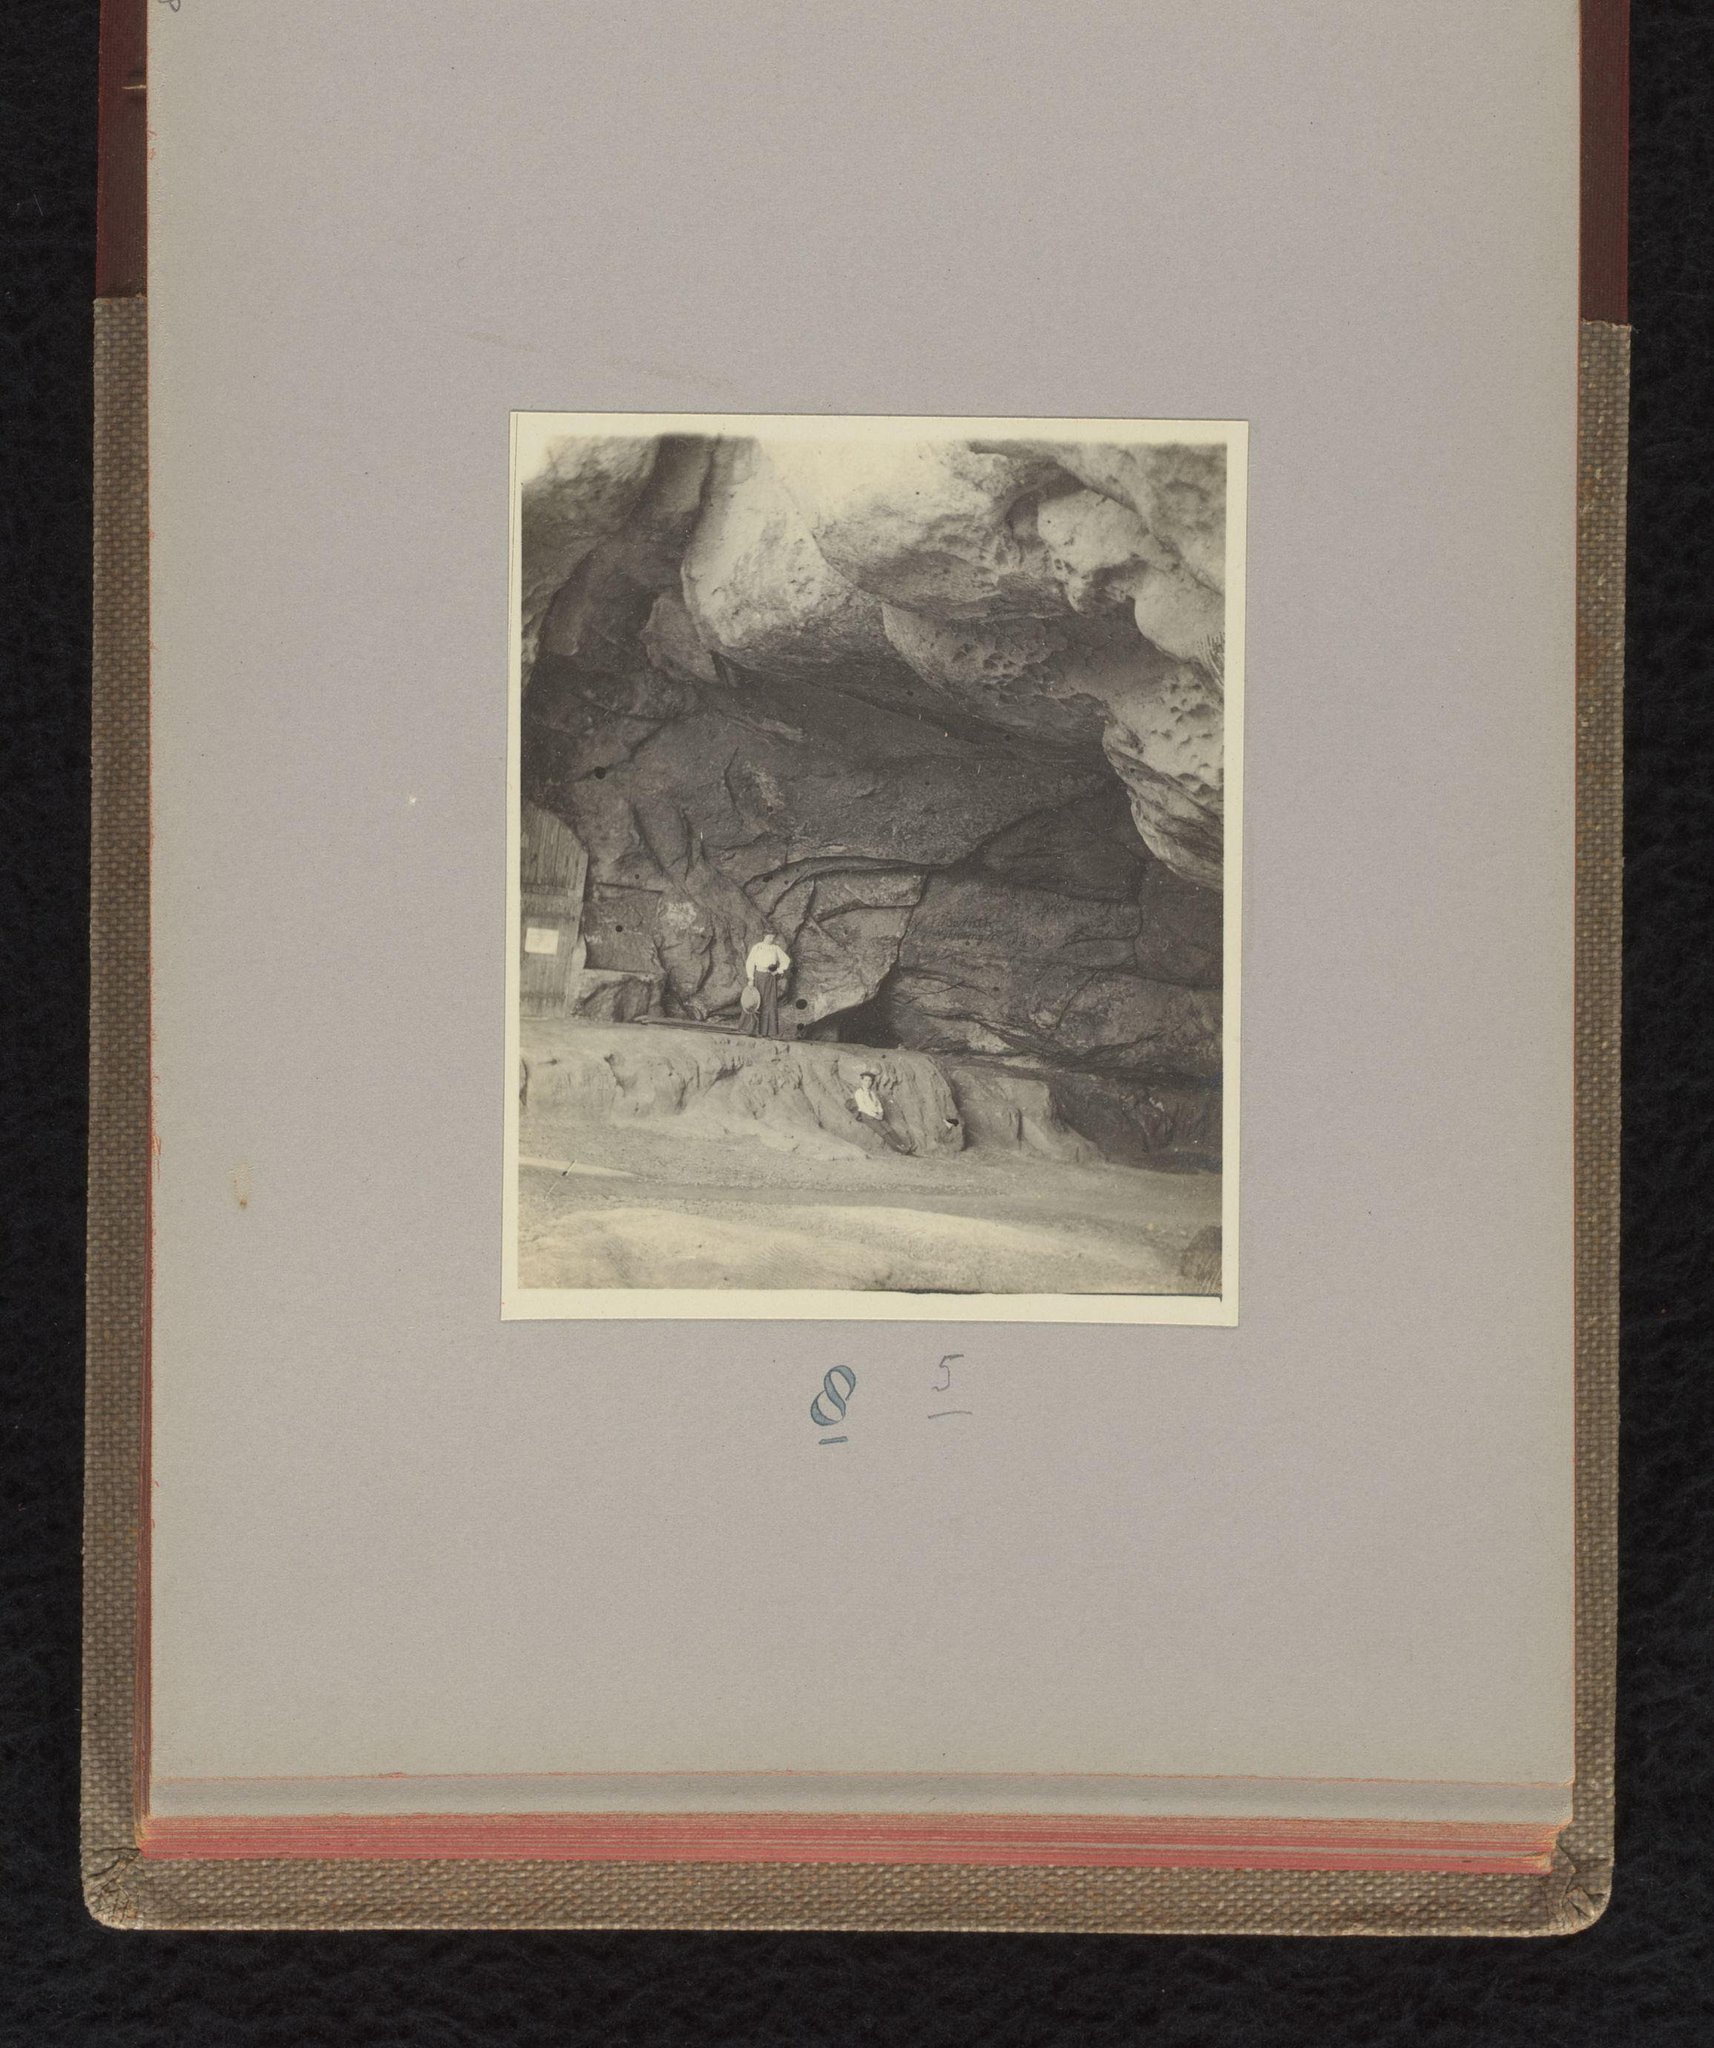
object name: photograph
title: Go en Boelie Kessler in de Kuhstall in Saksen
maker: johan herman kessler (jan)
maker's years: 1892-1978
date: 1910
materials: paper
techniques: gelatin silver print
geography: saxony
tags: the hague, hermann johannes kessler (boelie), cave, grotto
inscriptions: number: ‘8’